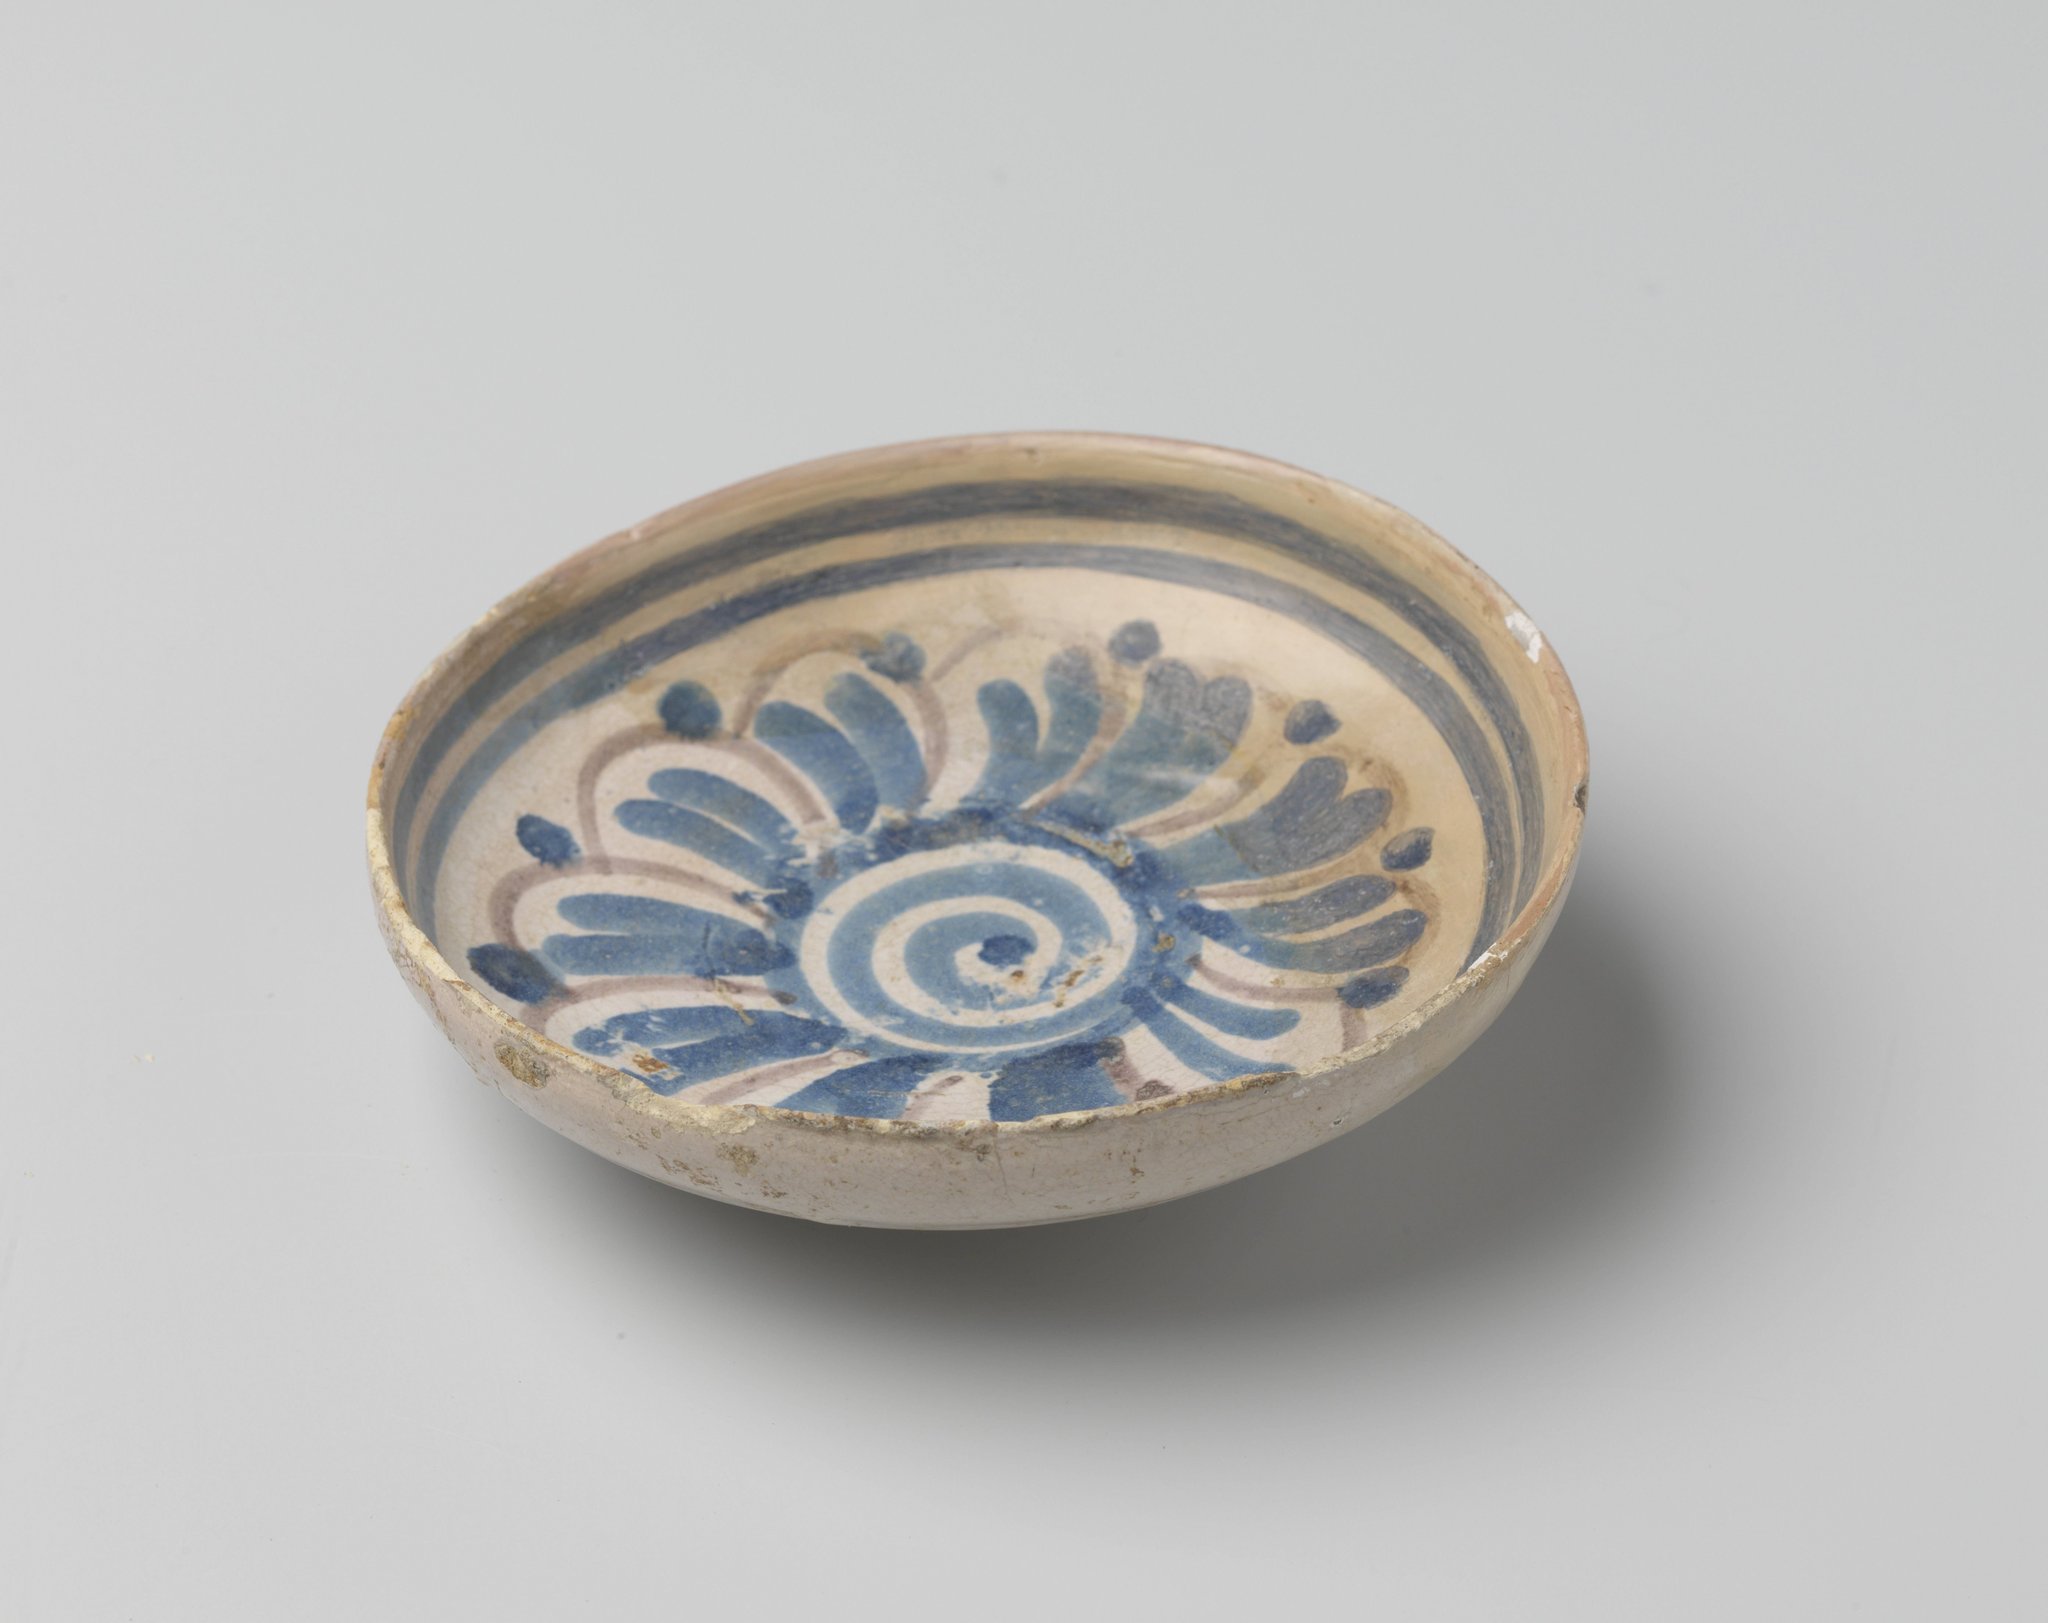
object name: platter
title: Schotel van aardewerk versierd met geometrische ornamenten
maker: Anonymous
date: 1640-1670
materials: earthenware, glaze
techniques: maiolica, painted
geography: england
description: Ronde schotel van blauw en paars beschilderde majolica, versierd met een bloemvormig ornament en langs de rand concentrische cirkels. Opgegraven in Londen. De schotel is gerestaureerd.